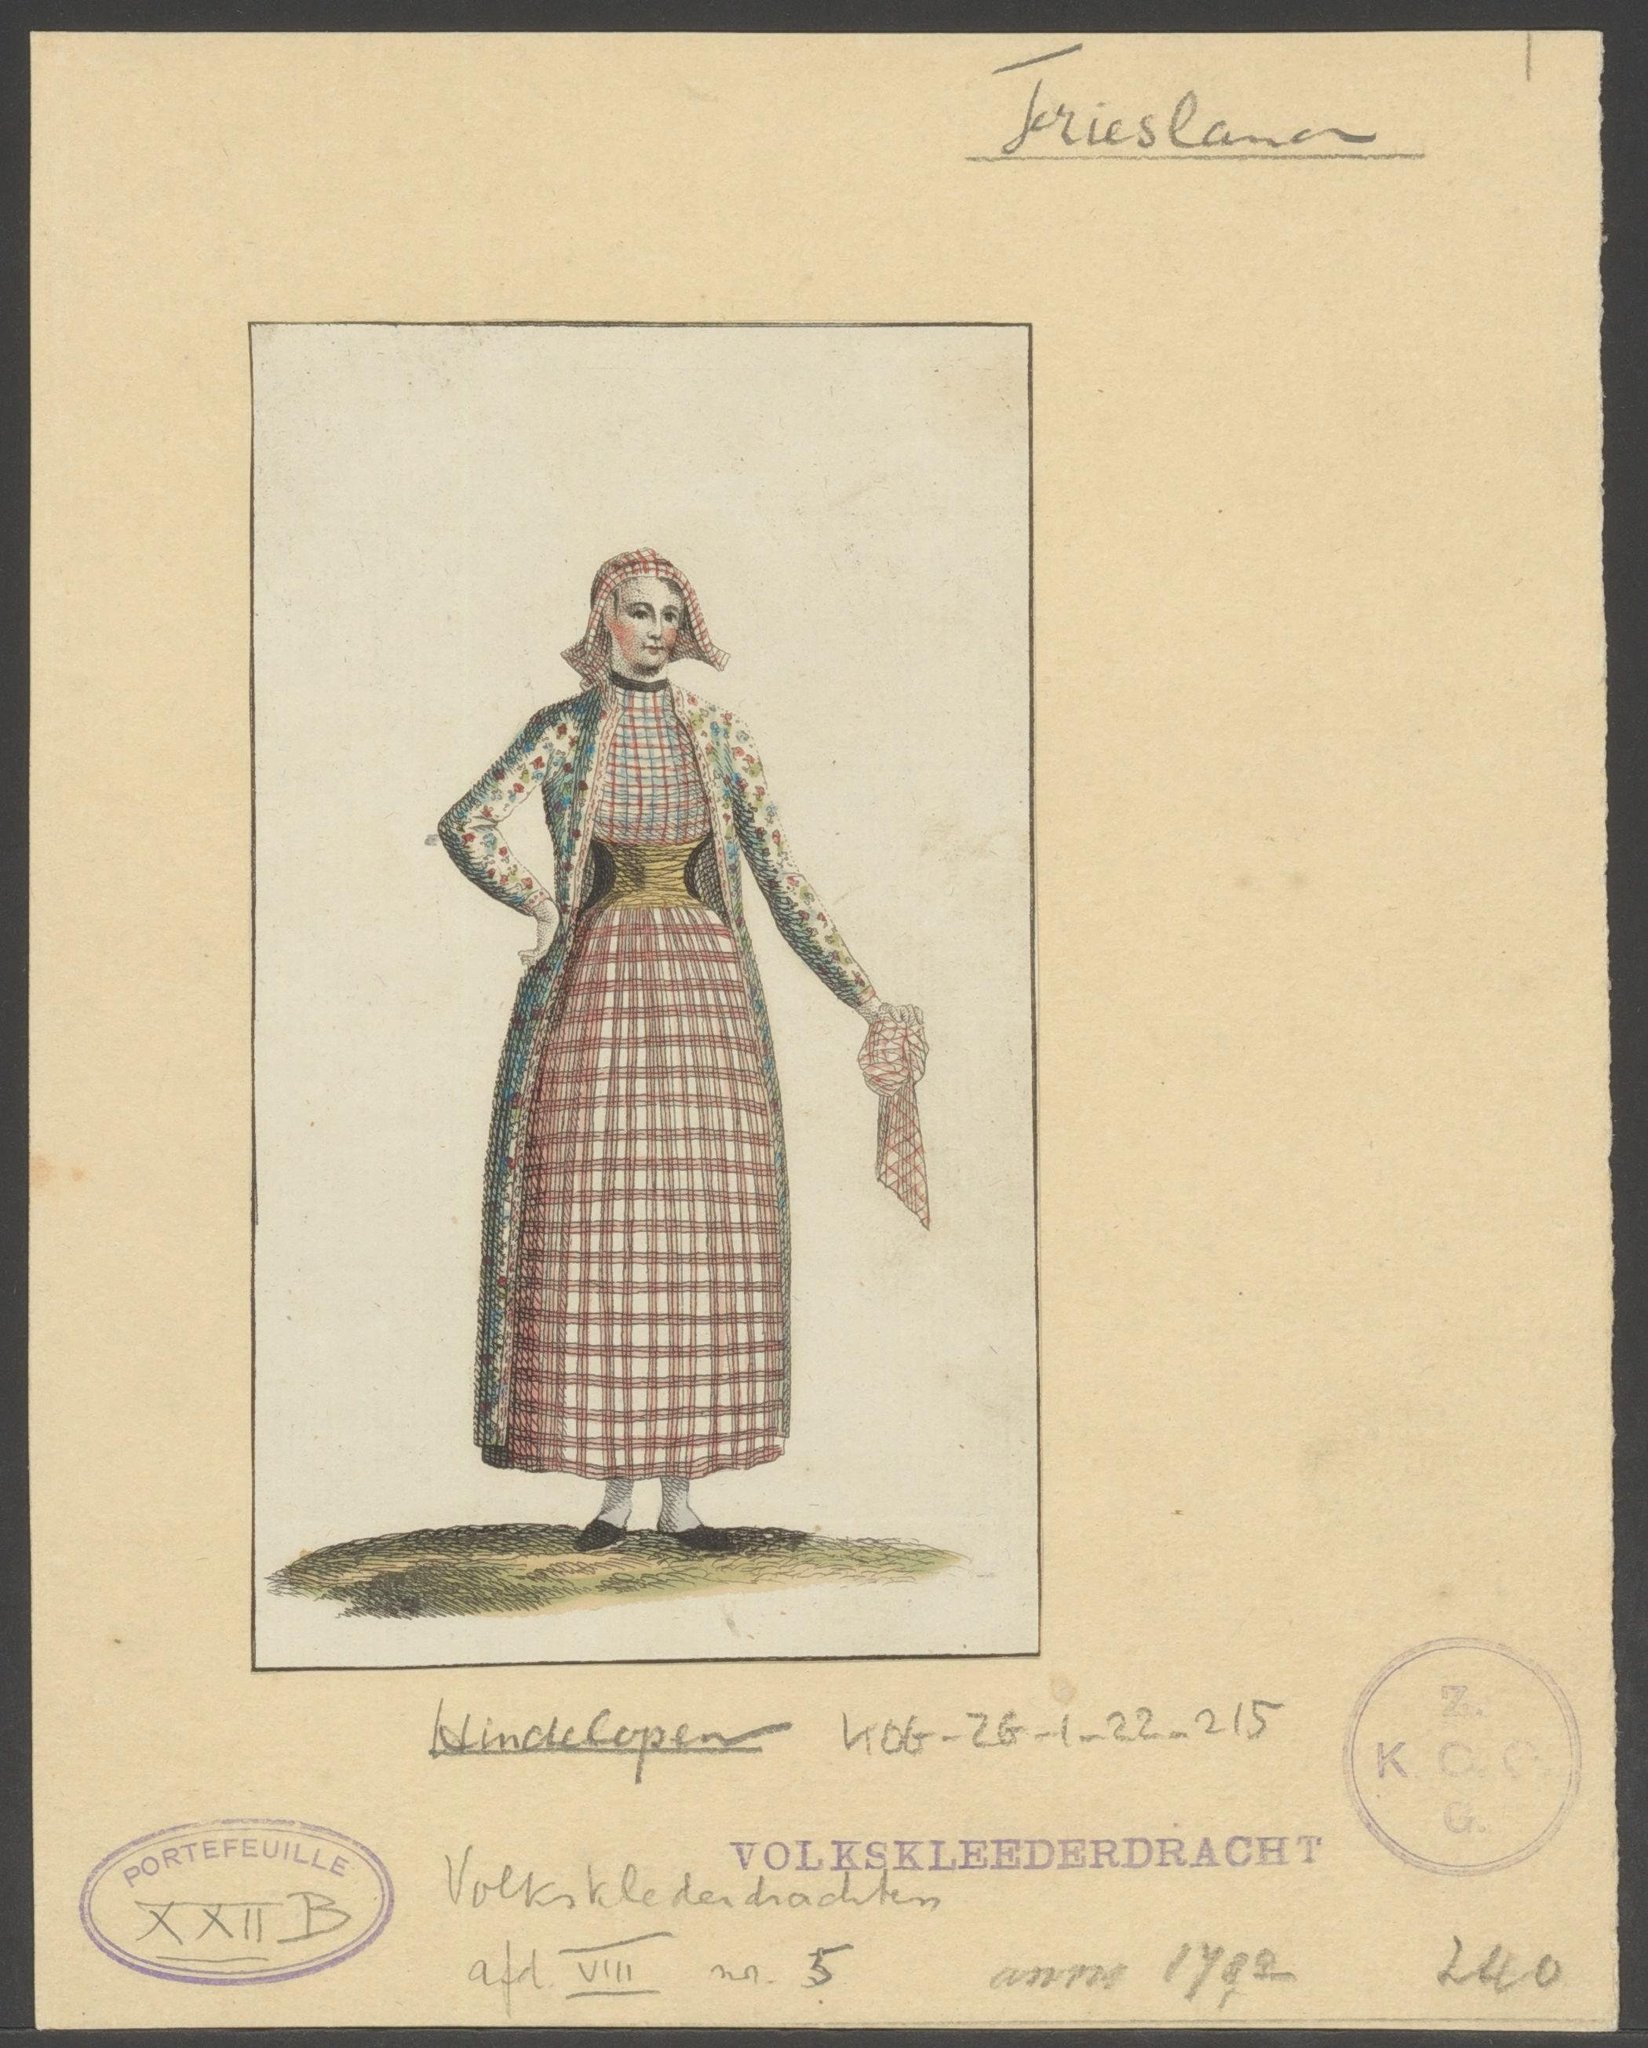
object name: book illustration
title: Vrouw van Hindeloopen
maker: Anonymous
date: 1792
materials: paper, watercolor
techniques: etching, hand coloring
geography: netherlands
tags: clothes, costume (+ women's clothes), folk costume, regional costume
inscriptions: collector's mark: Lugt 1641, collector's mark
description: Vrouw van Hindeloopen. Staande met een hand in de zij en in de andere een doek. Onderwerpsrubrieken binnen de Atlas Zeden en Gewoonten: De Kleeding, Volkskleederdracht, Friesland.